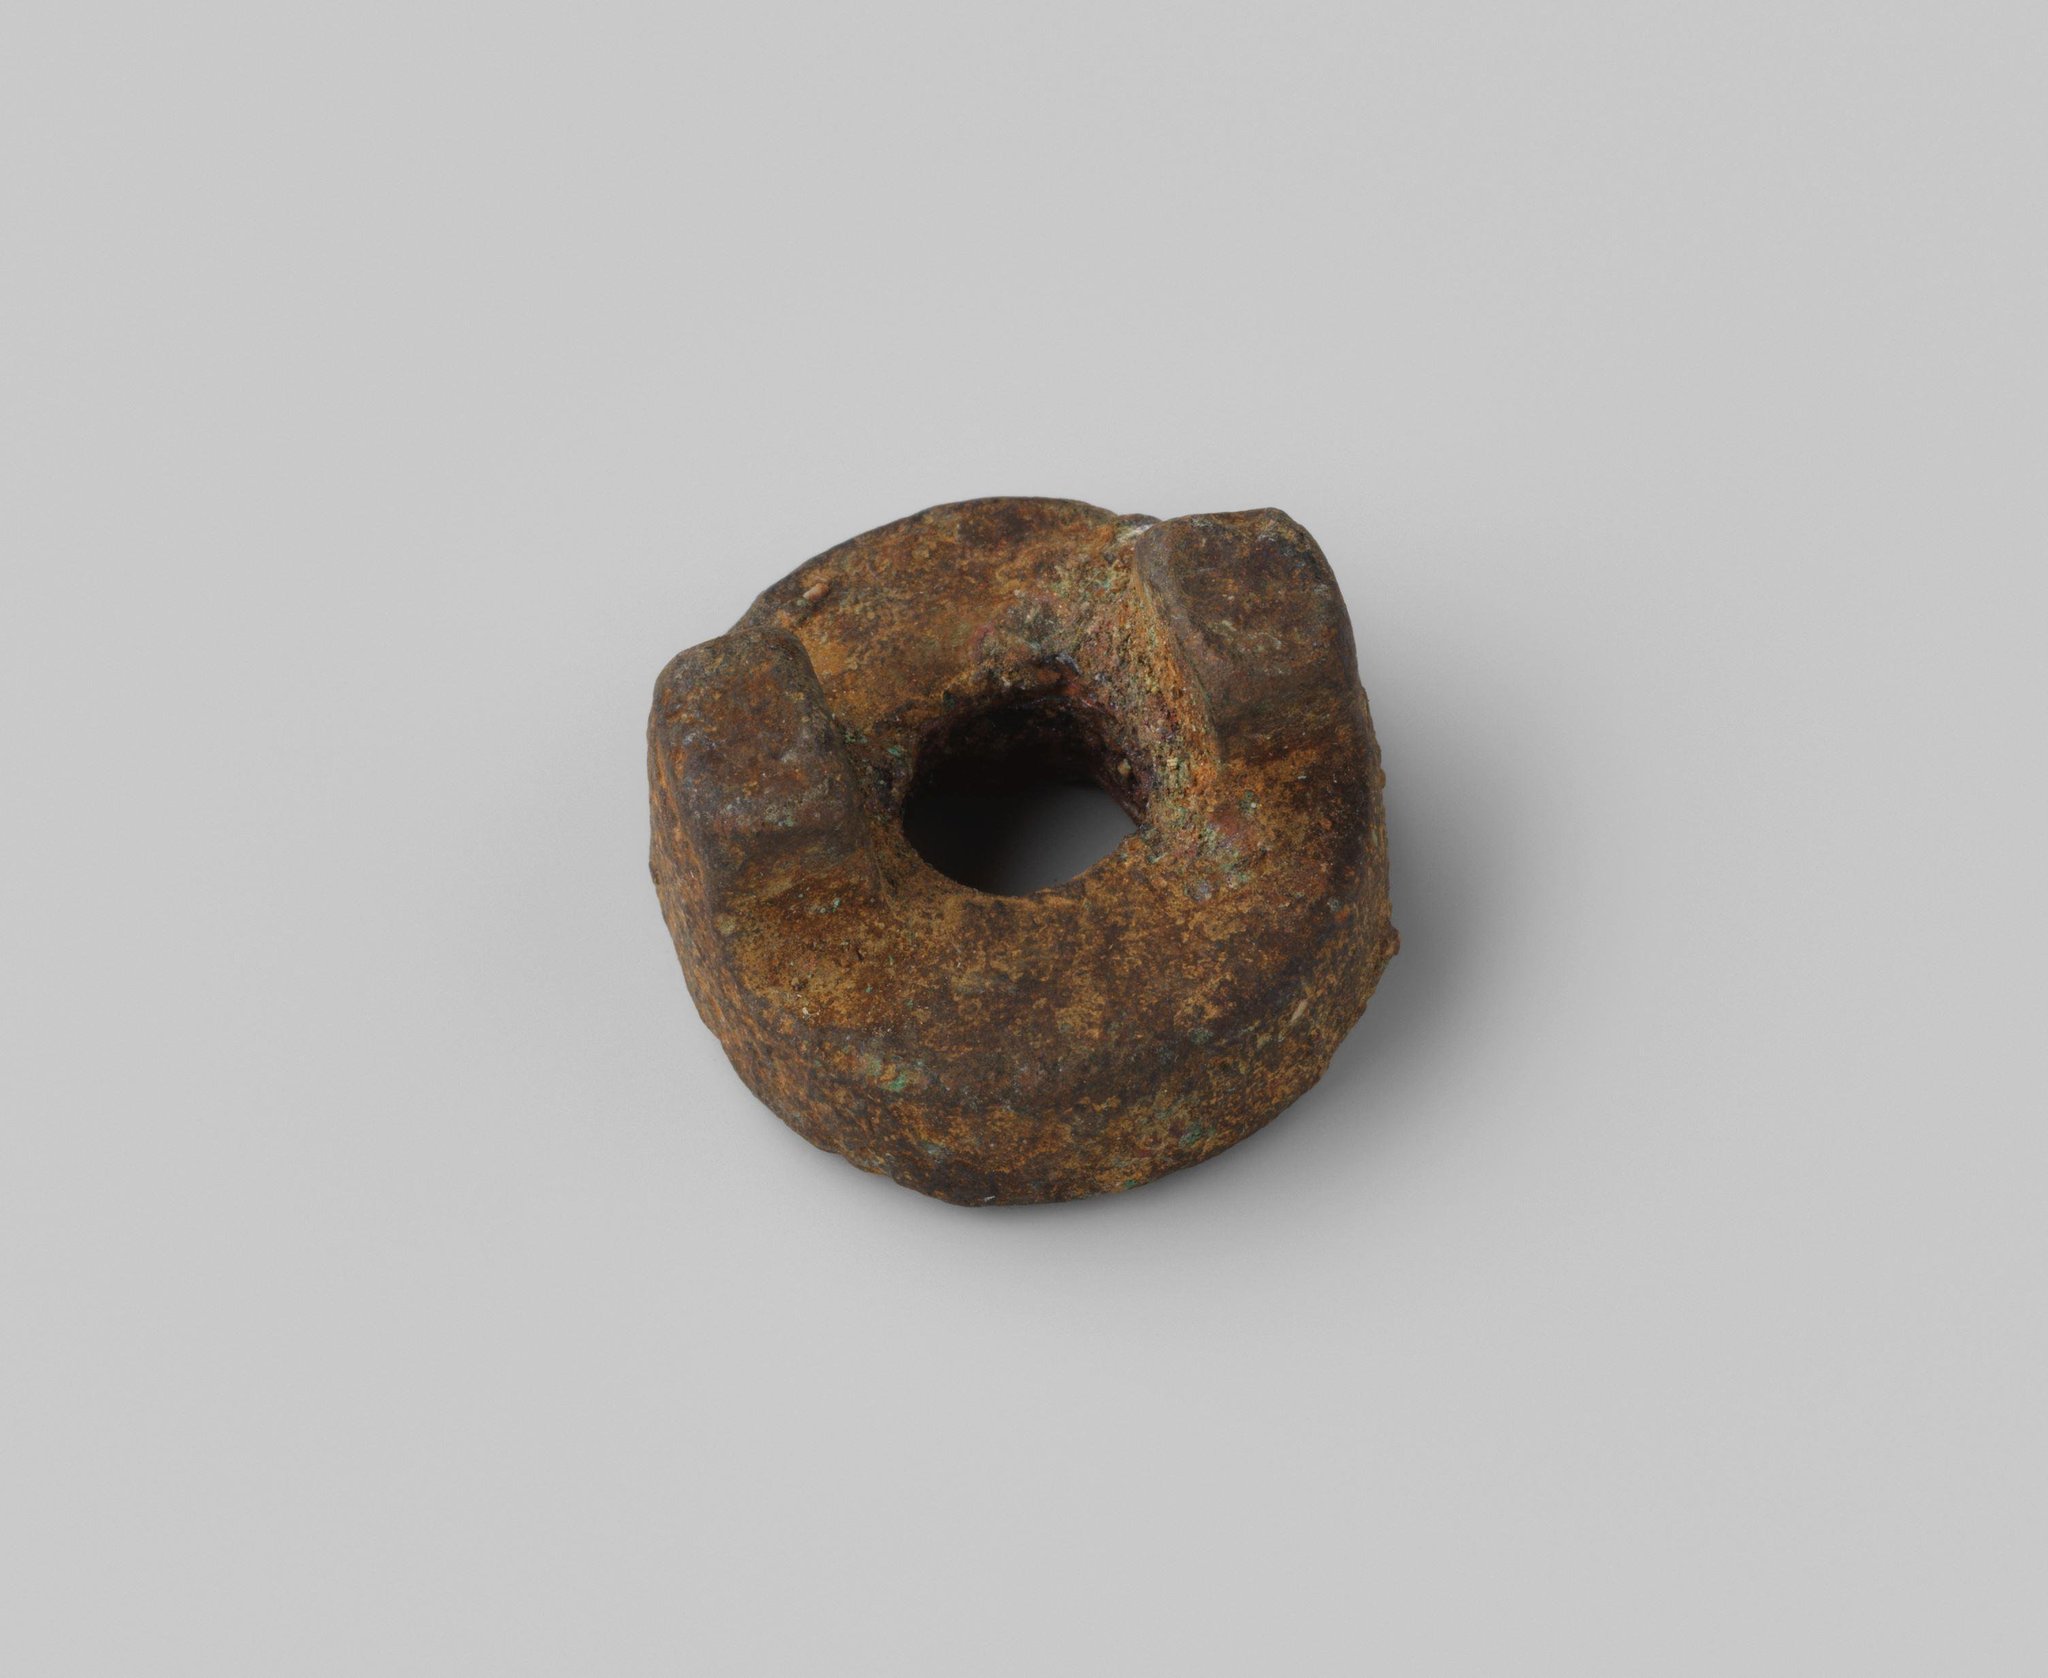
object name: nut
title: Moer uit het wrak van de Oost-Indiëvaarder Hollandia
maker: Anonymous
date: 1743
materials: copper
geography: netherlands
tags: verenigde oostindische compagnie, hollandia (schip), annet